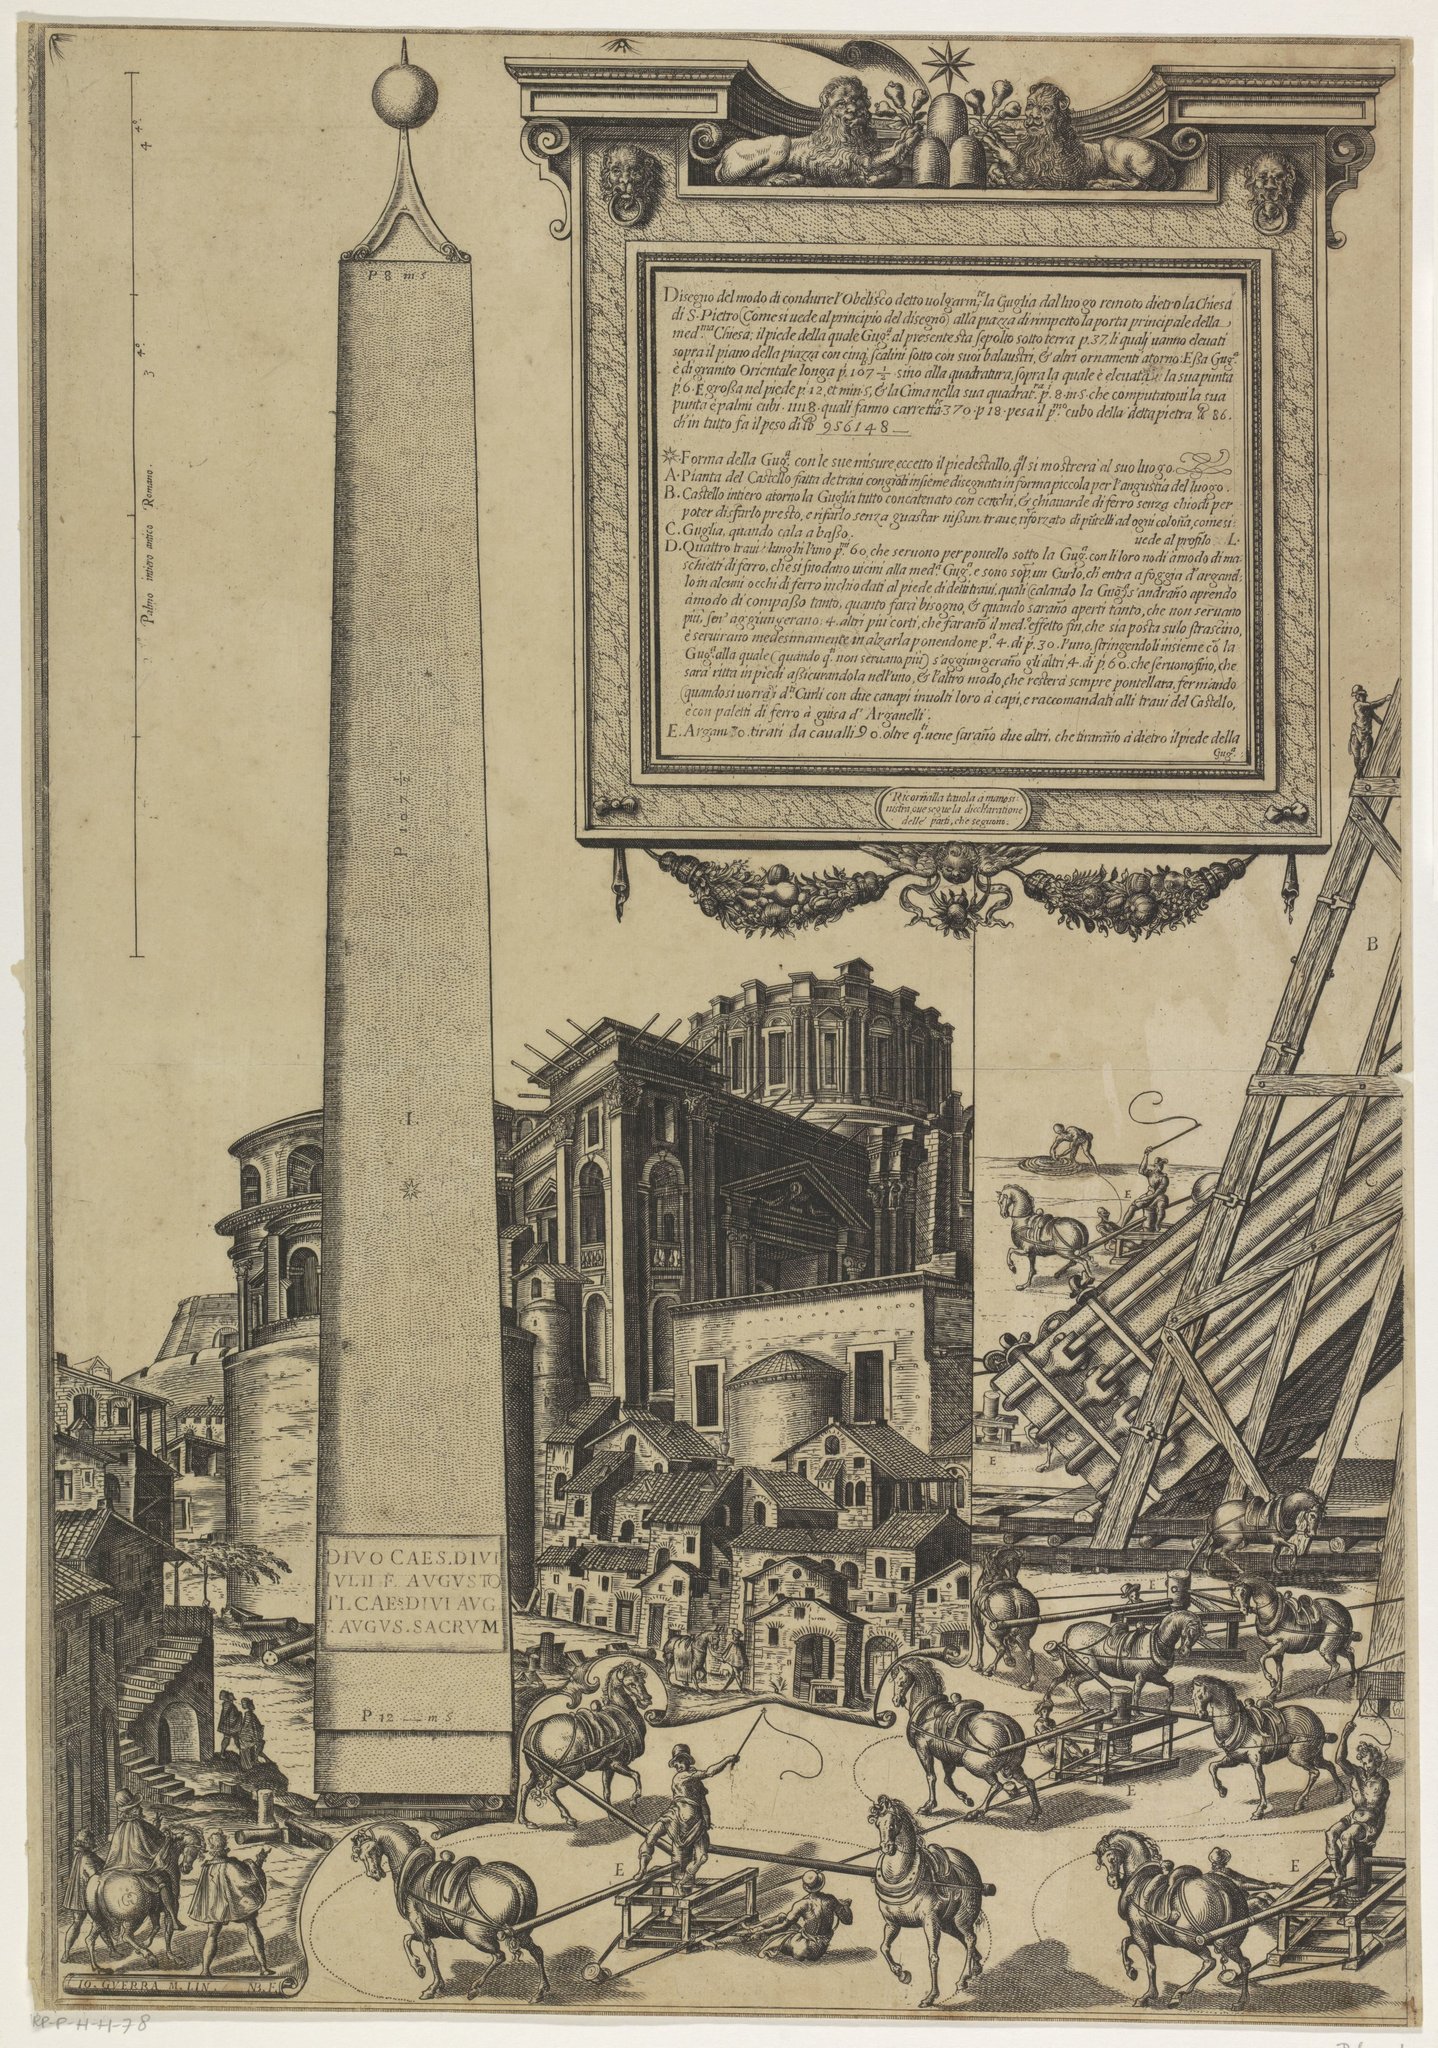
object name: print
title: Domenico Fontana da Mili diocesi di Como inventore et conduttore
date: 1586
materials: paper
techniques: engraving, etching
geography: rome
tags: obelisk, needle, roman catholic church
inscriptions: collector's mark: Lugt 11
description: Links de Vaticaanse Obelisk die rechtop staat, bekroond met een koperen bol. Rechts mannen en paarden die de Vaticaanse Obelisk op zijn nieuwe plek, het St. Pietersplein, rechtop zetten met behulp van een houten stellage. Rechtsboven een sierlijst met tekst.